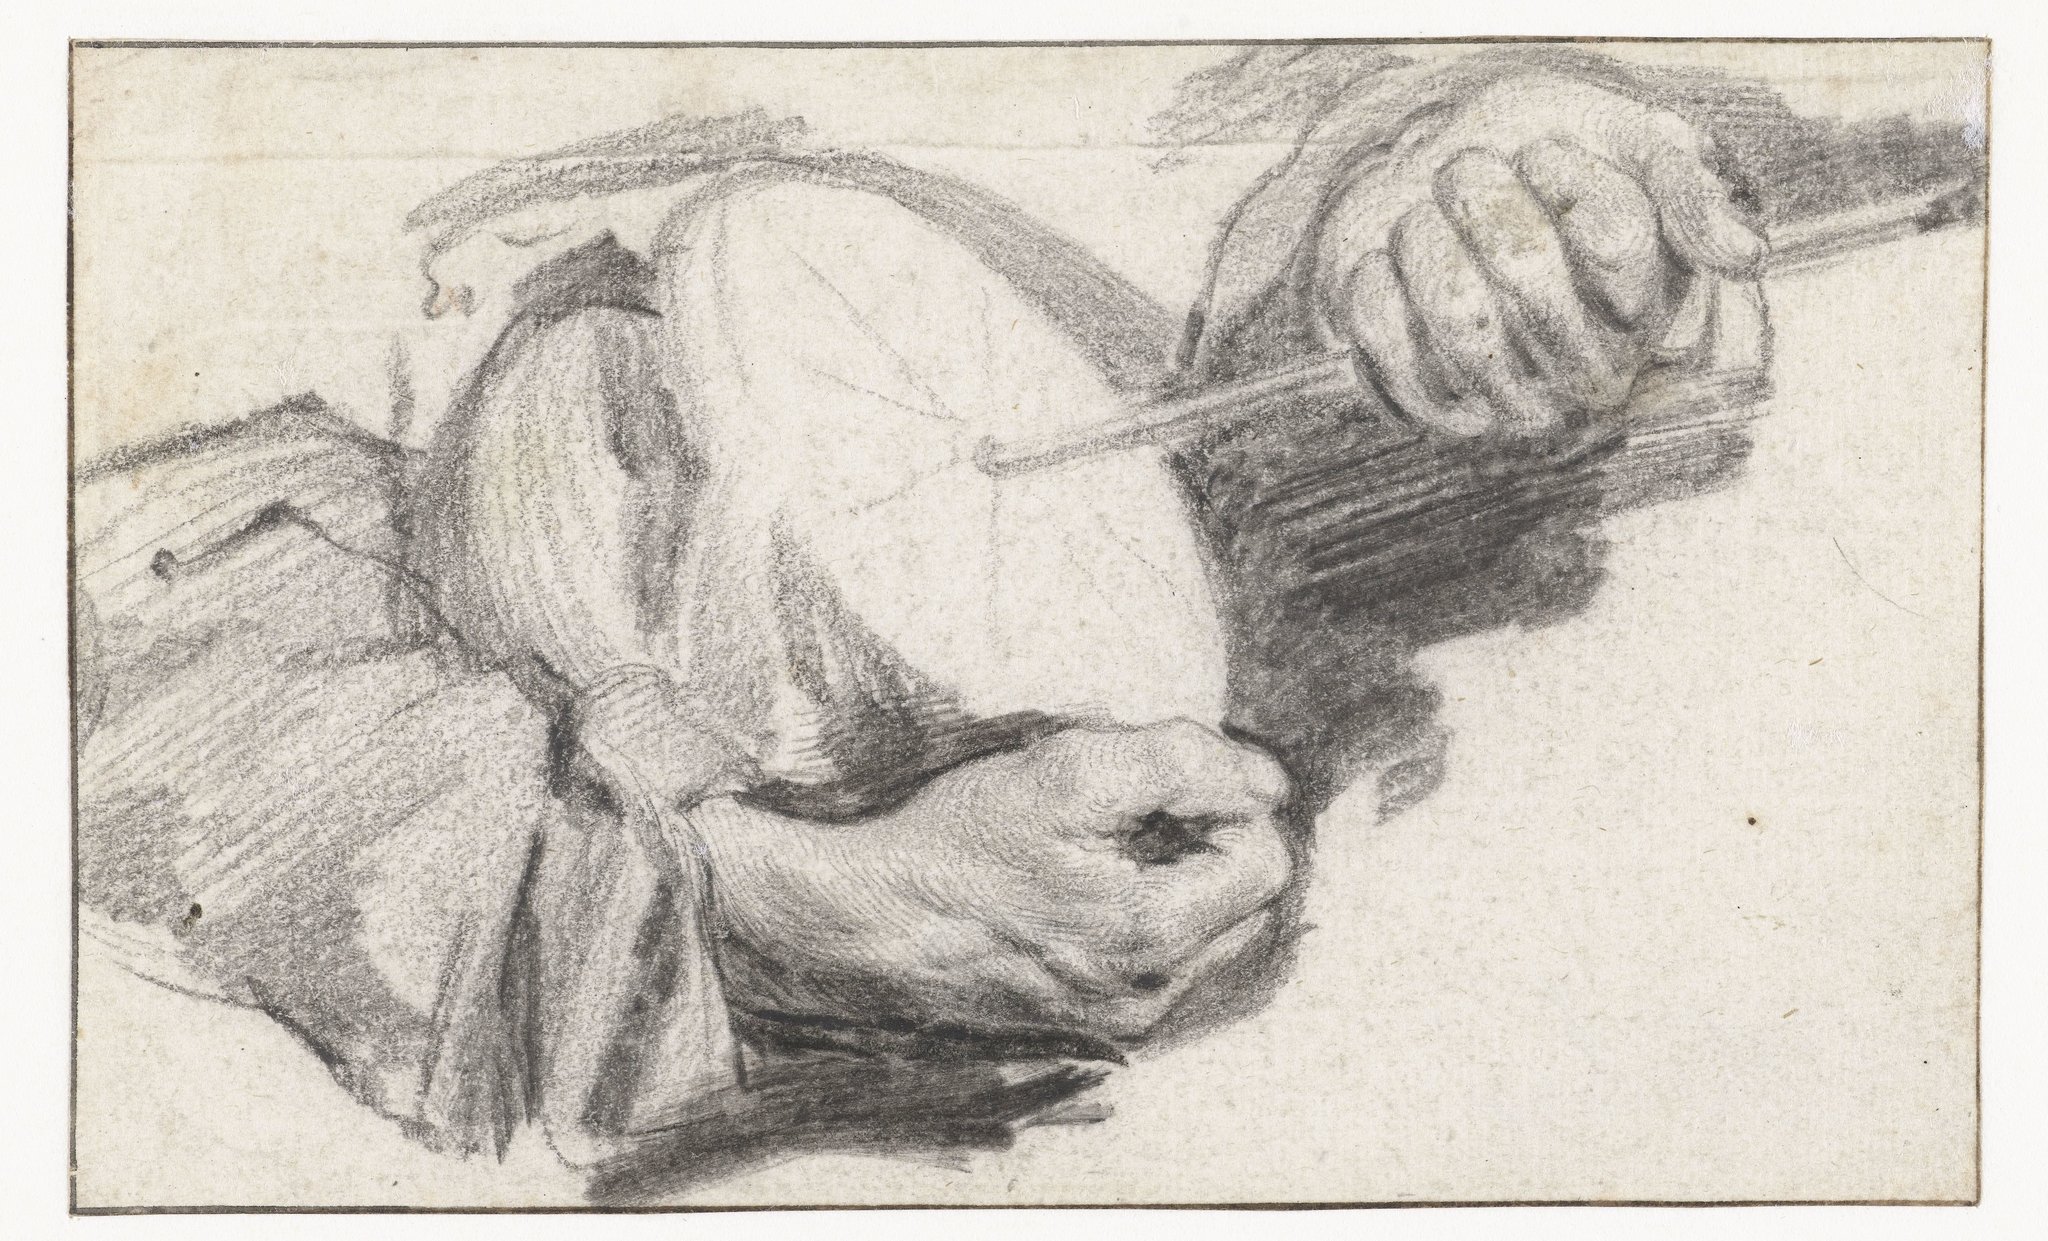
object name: drawing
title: Hands of a Rommelpot Player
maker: cornelis visscher (ii)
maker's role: draughtsman, painter, print maker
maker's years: 1628-1658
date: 1654-1658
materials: chalk, paper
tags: hand, improvised musical instruments: rumbling pot, instrumental popular music